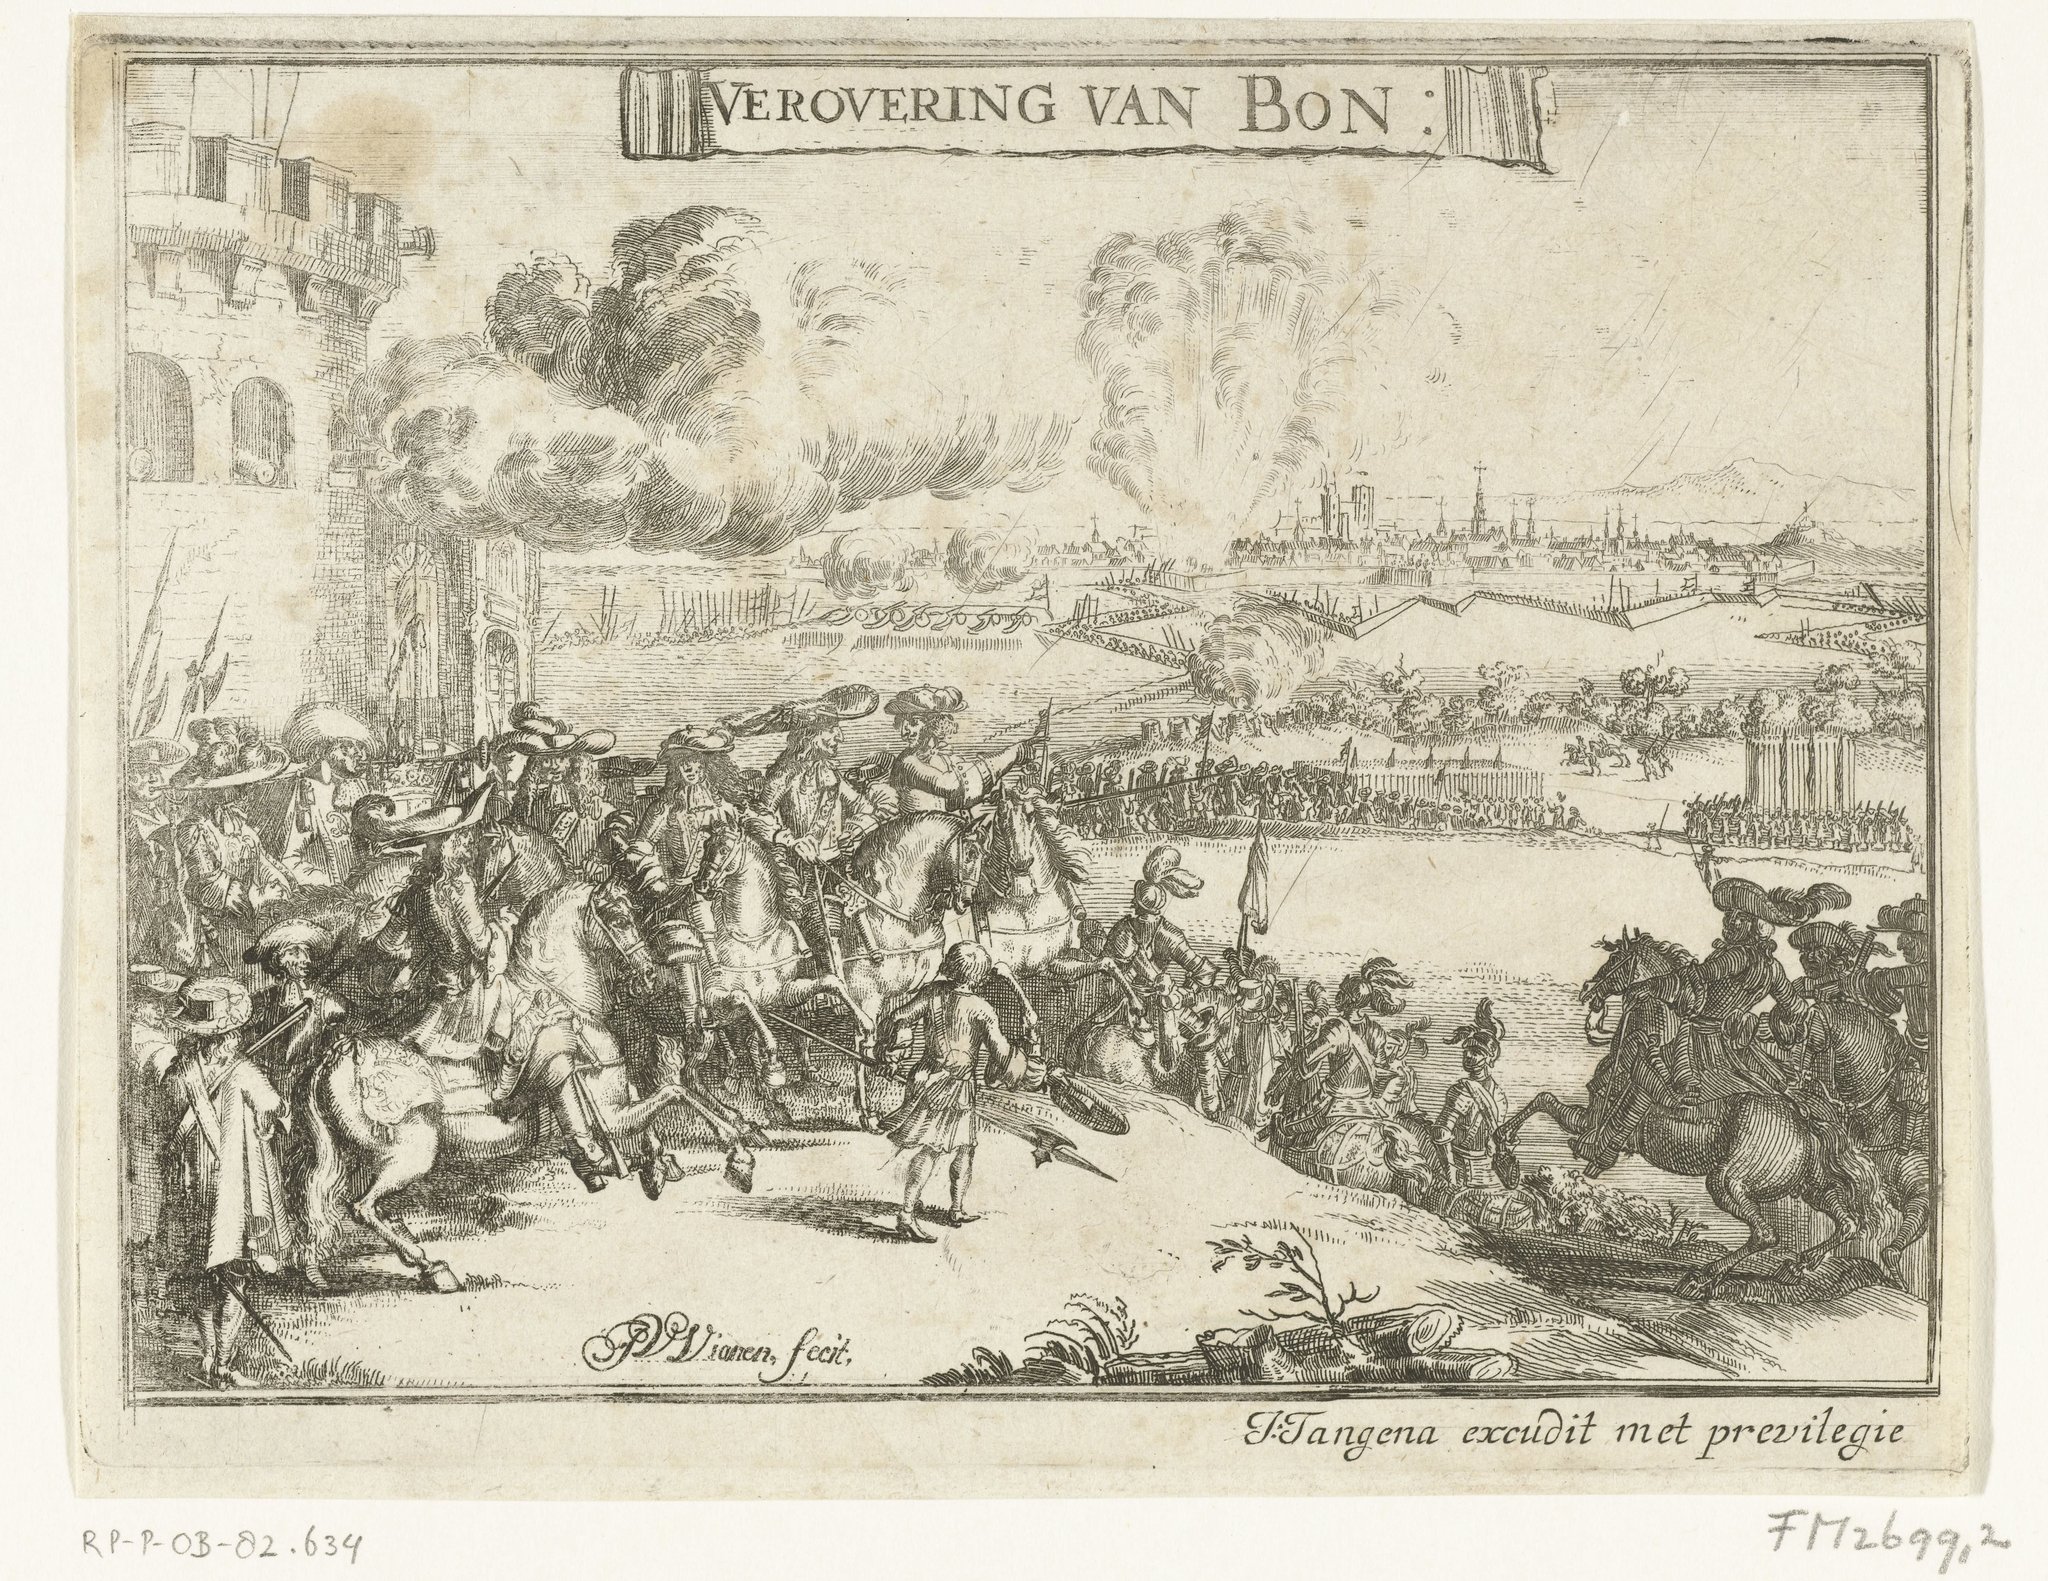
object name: print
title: Overwinningen van koning Willem III, 1690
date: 1690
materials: paper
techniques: etching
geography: northern netherlands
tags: william iii (prince of orange and king of england, scotland, and ireland), siege, position war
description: Beleg en inname van de stad Bonn door troepen onder koning Willem III, 10 oktober 1689. Onderdeel van een serie van overwinningen van koning Willem III in 1690.